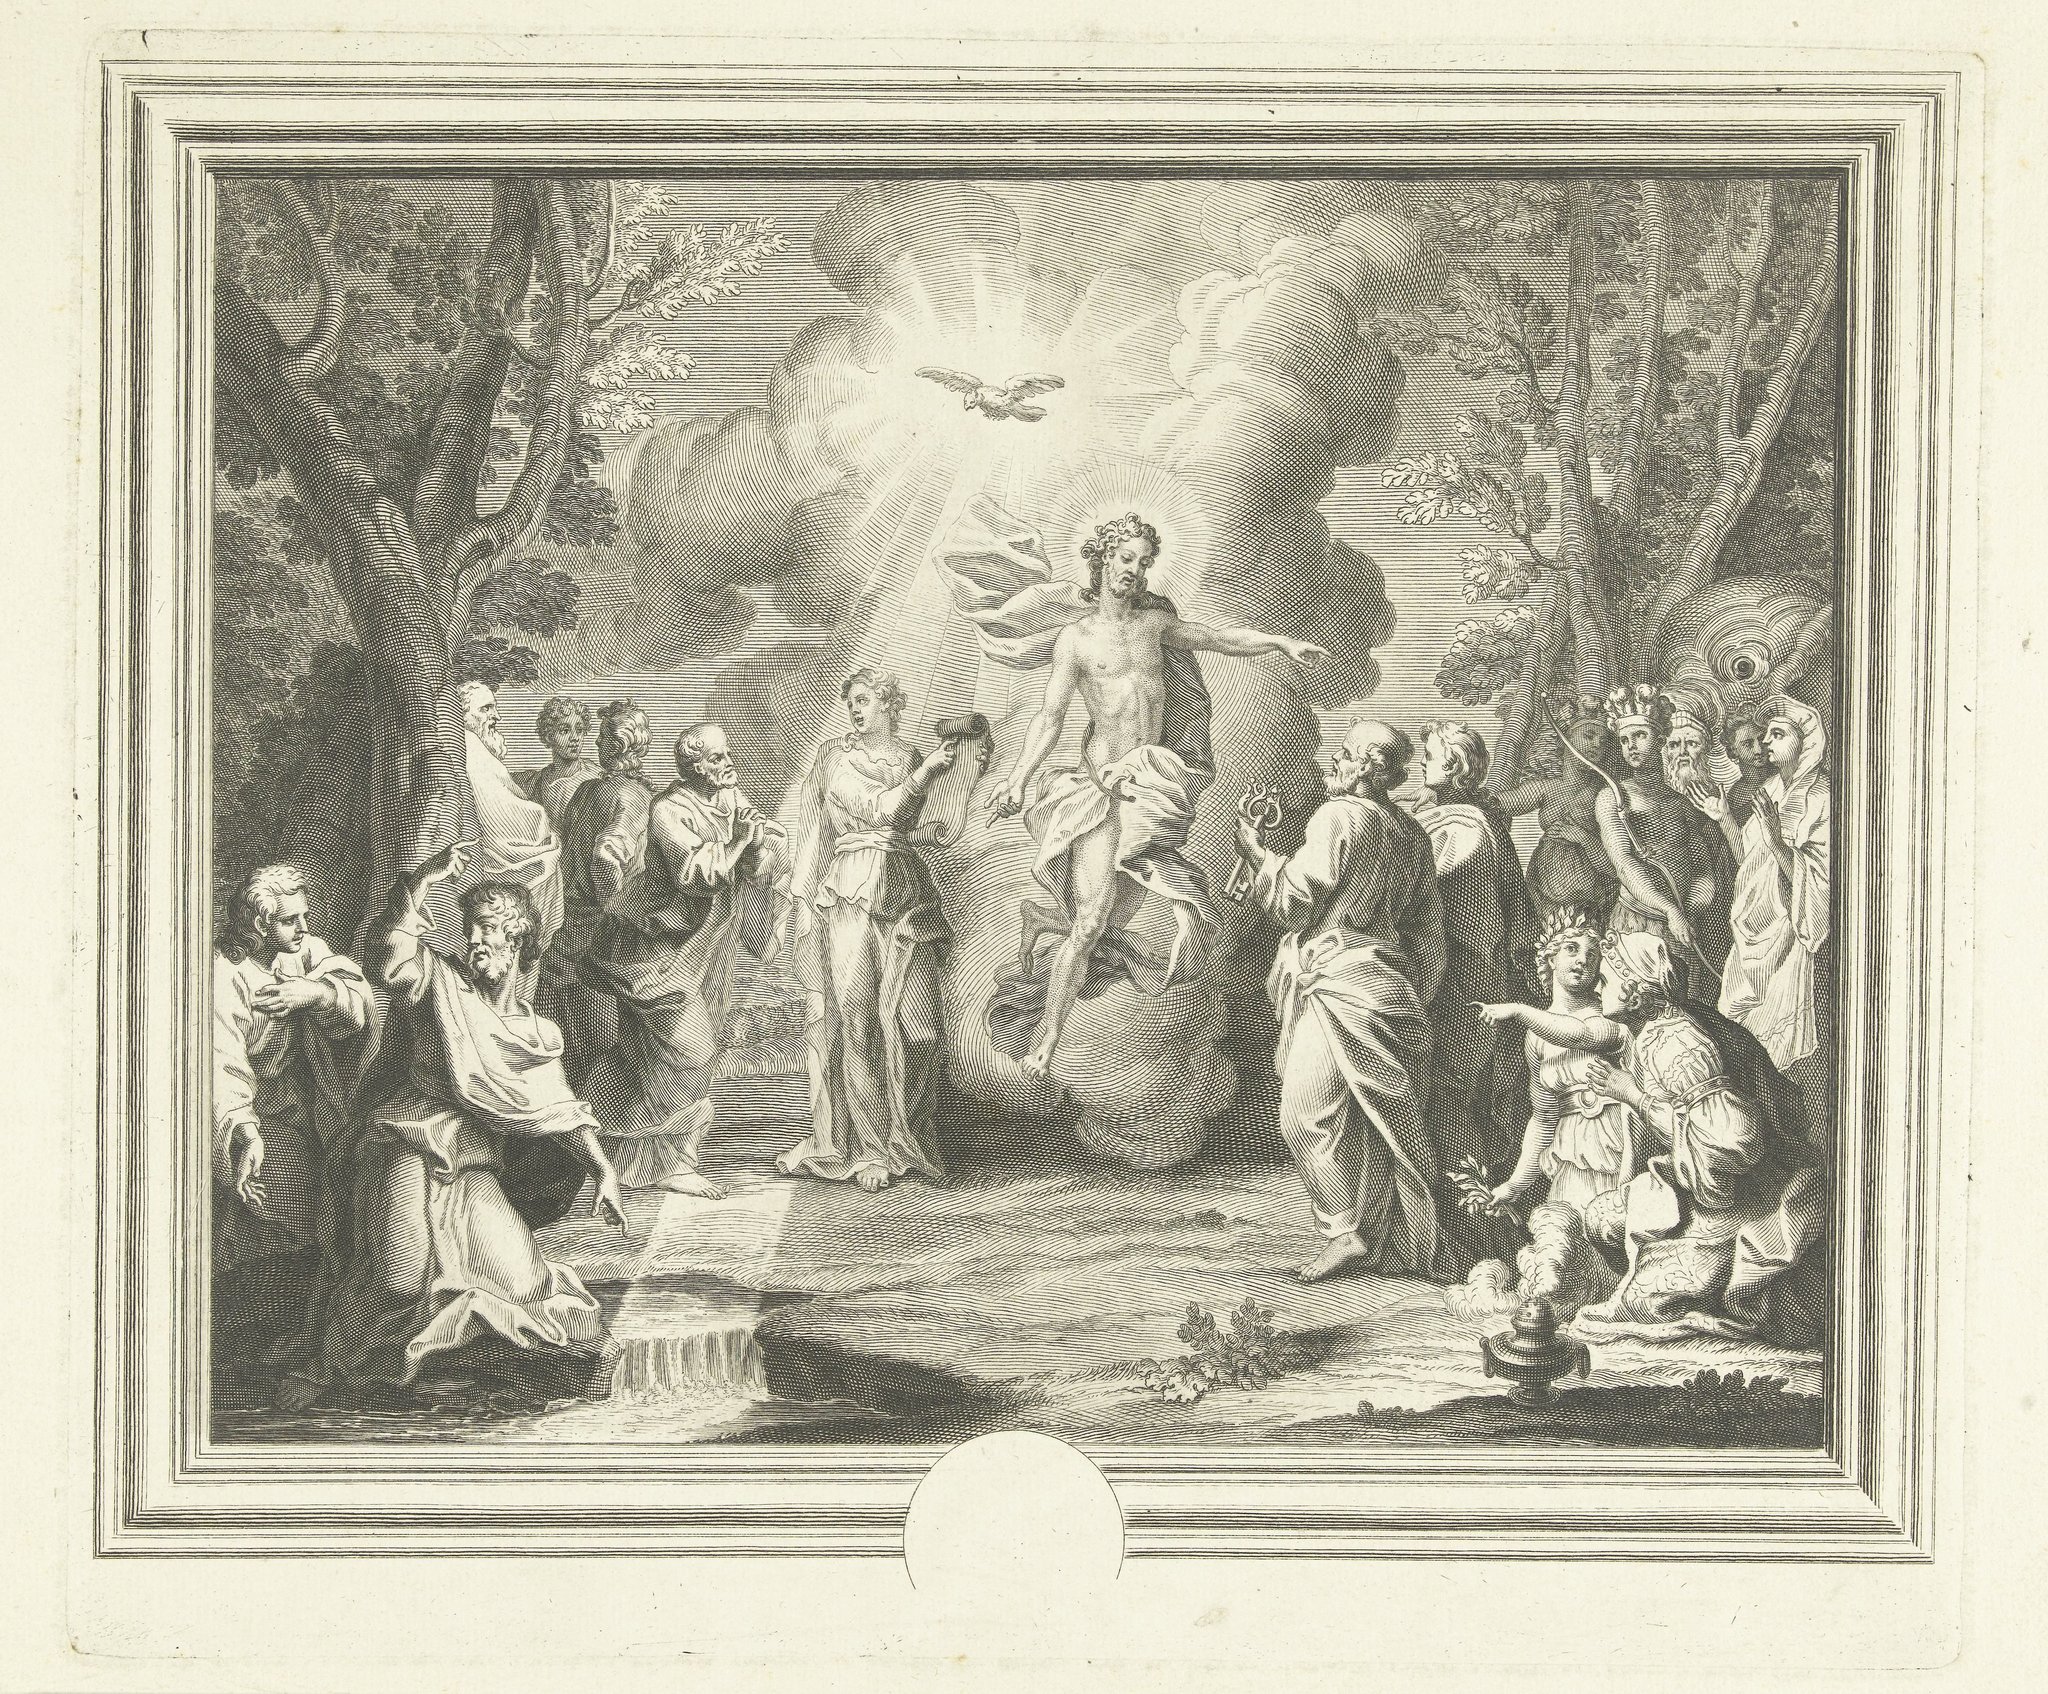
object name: print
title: Hemelvaart van Christus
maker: gerard edelinck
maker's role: print maker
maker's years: 1640-1707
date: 1652-1707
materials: paper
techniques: engraving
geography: paris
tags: the ascension (christ surrounded by radiant light or in a mandorla)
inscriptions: collector's mark: Lugt 240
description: Verschillende personen, waaronder de apostelen, kijken naar Christus die opstijgt in een grote wolk. Naast hem leest een engel een schriftrol voor en boven hem verspreidt de Heilige Geest in de vorm van een duif lichtstralen.